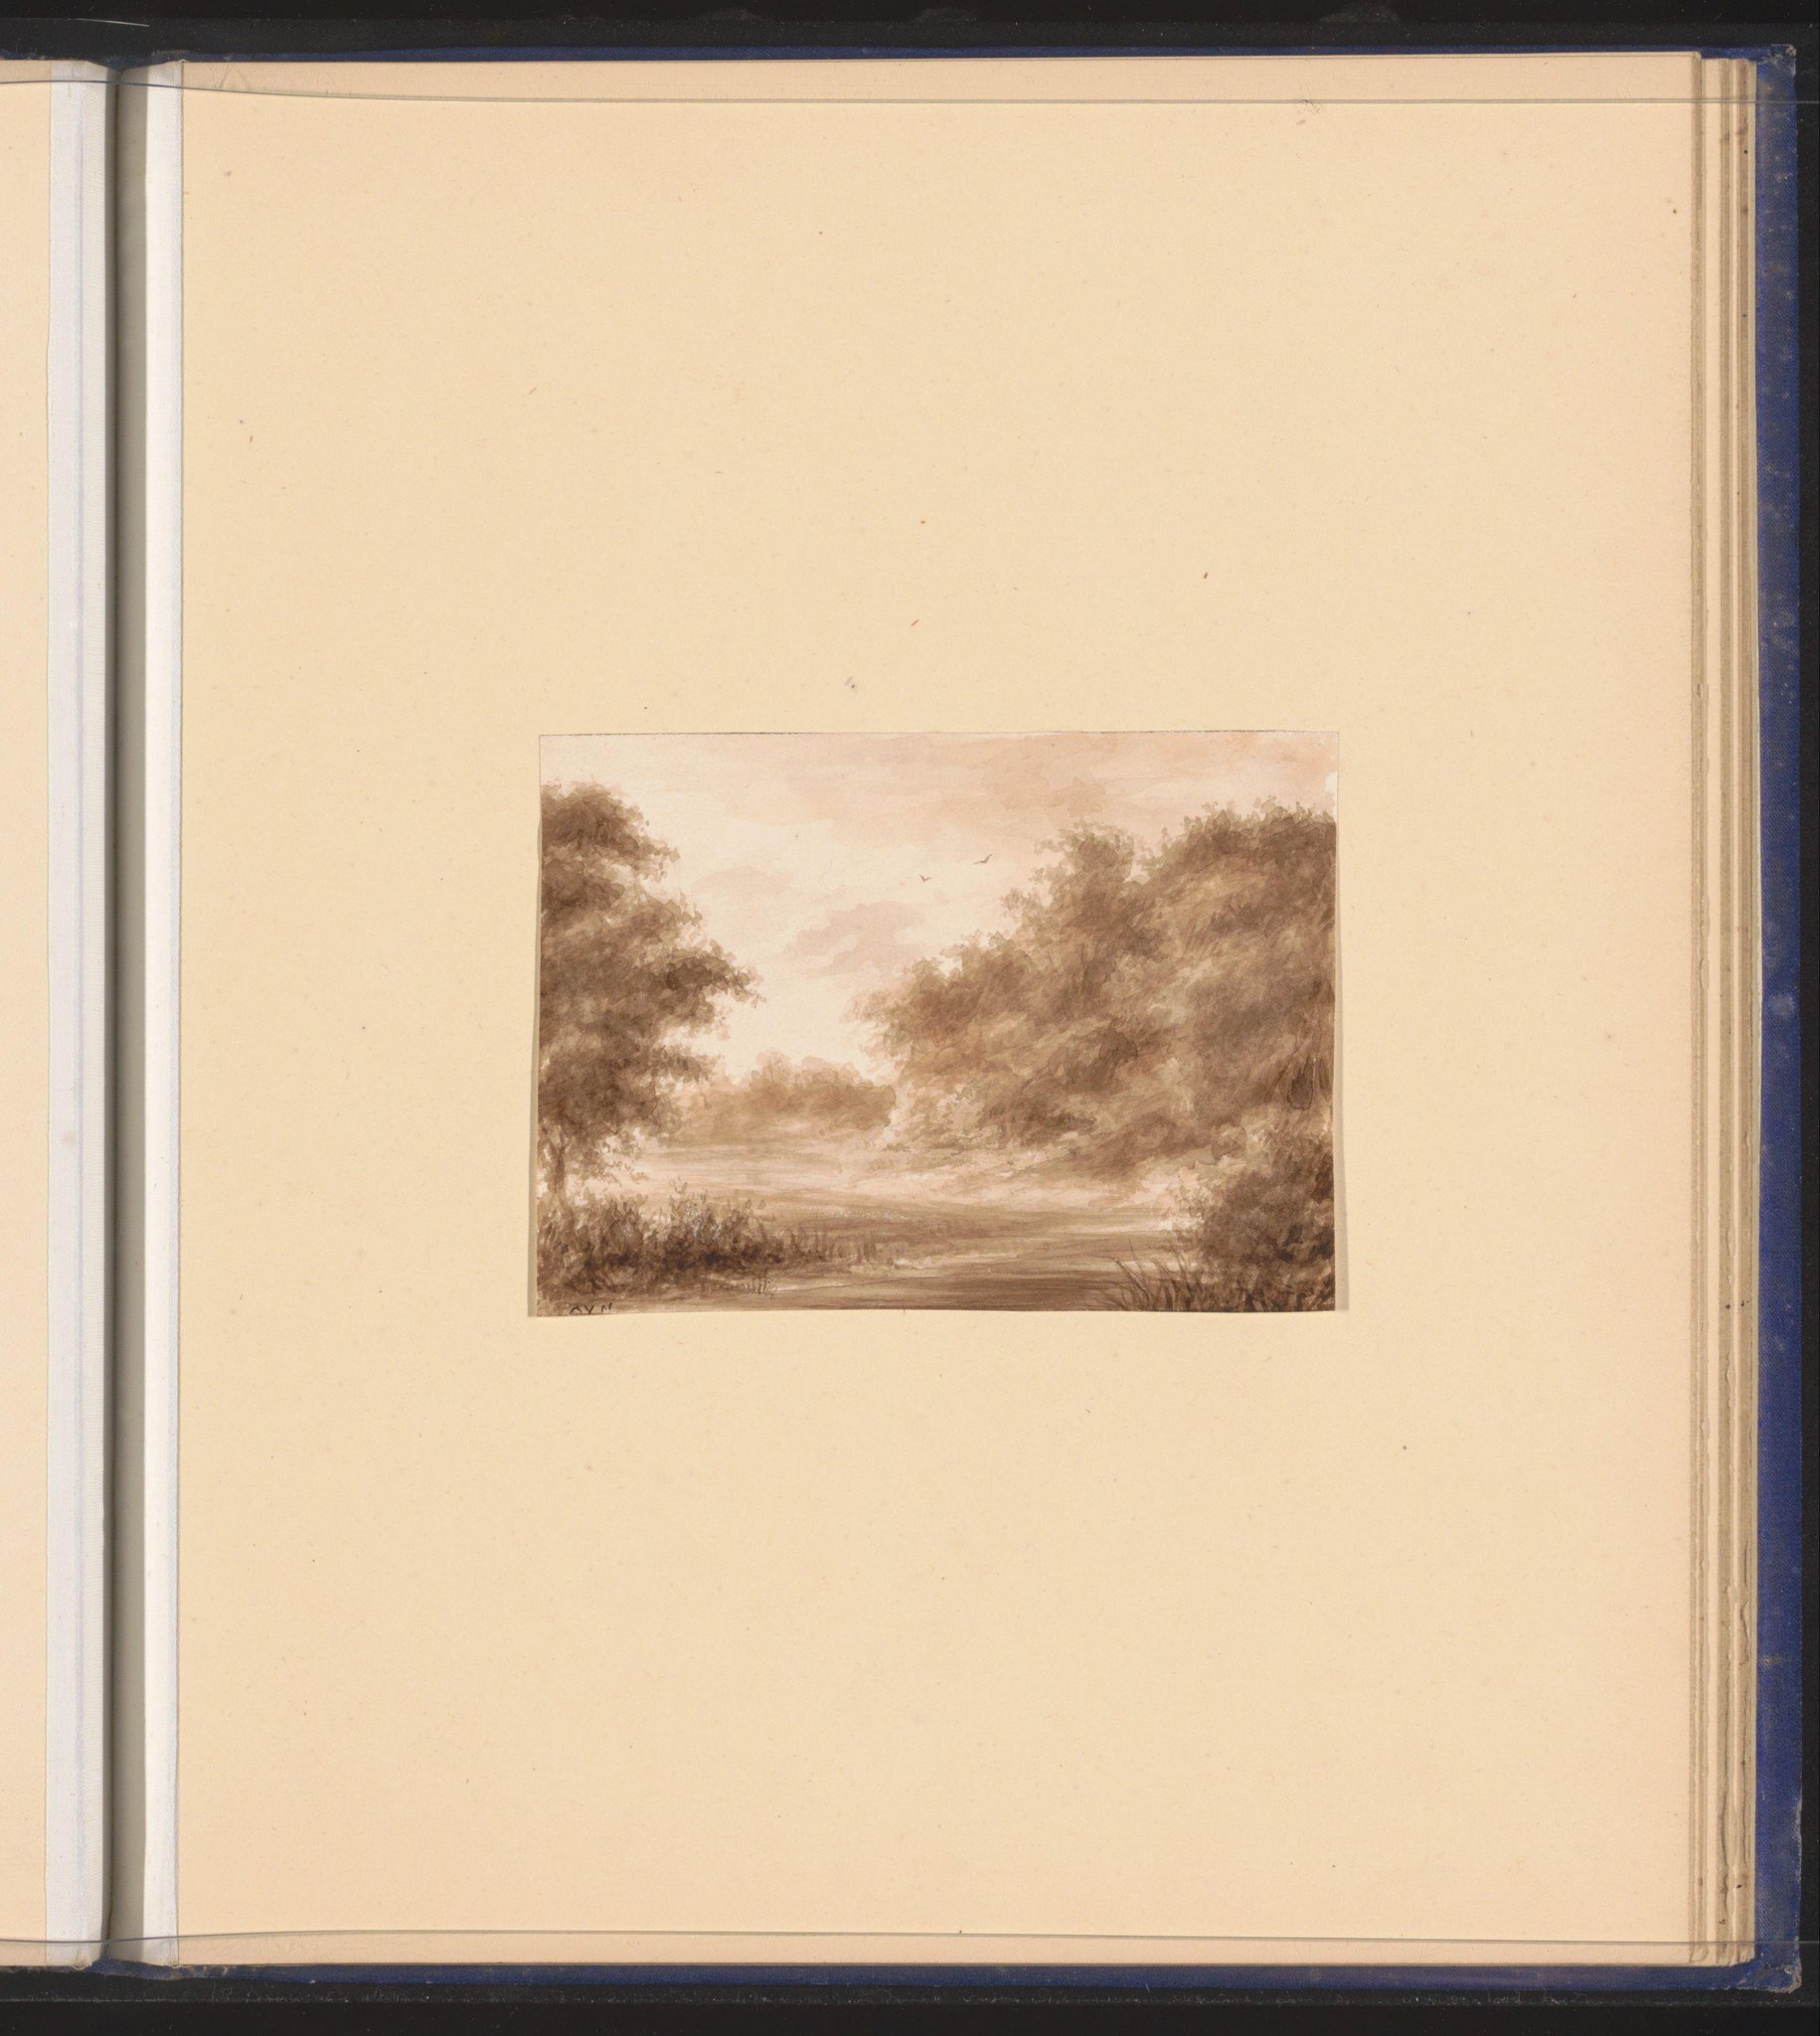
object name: album leaf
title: Landschap met rivier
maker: alexander ver huell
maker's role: draughtsman, print maker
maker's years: 1822-1897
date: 1882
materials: paper, watercolor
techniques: brush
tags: river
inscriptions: signature: ‘AVH’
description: Tekening op blad 18 van een album met 24 ingeplakte schetsen.